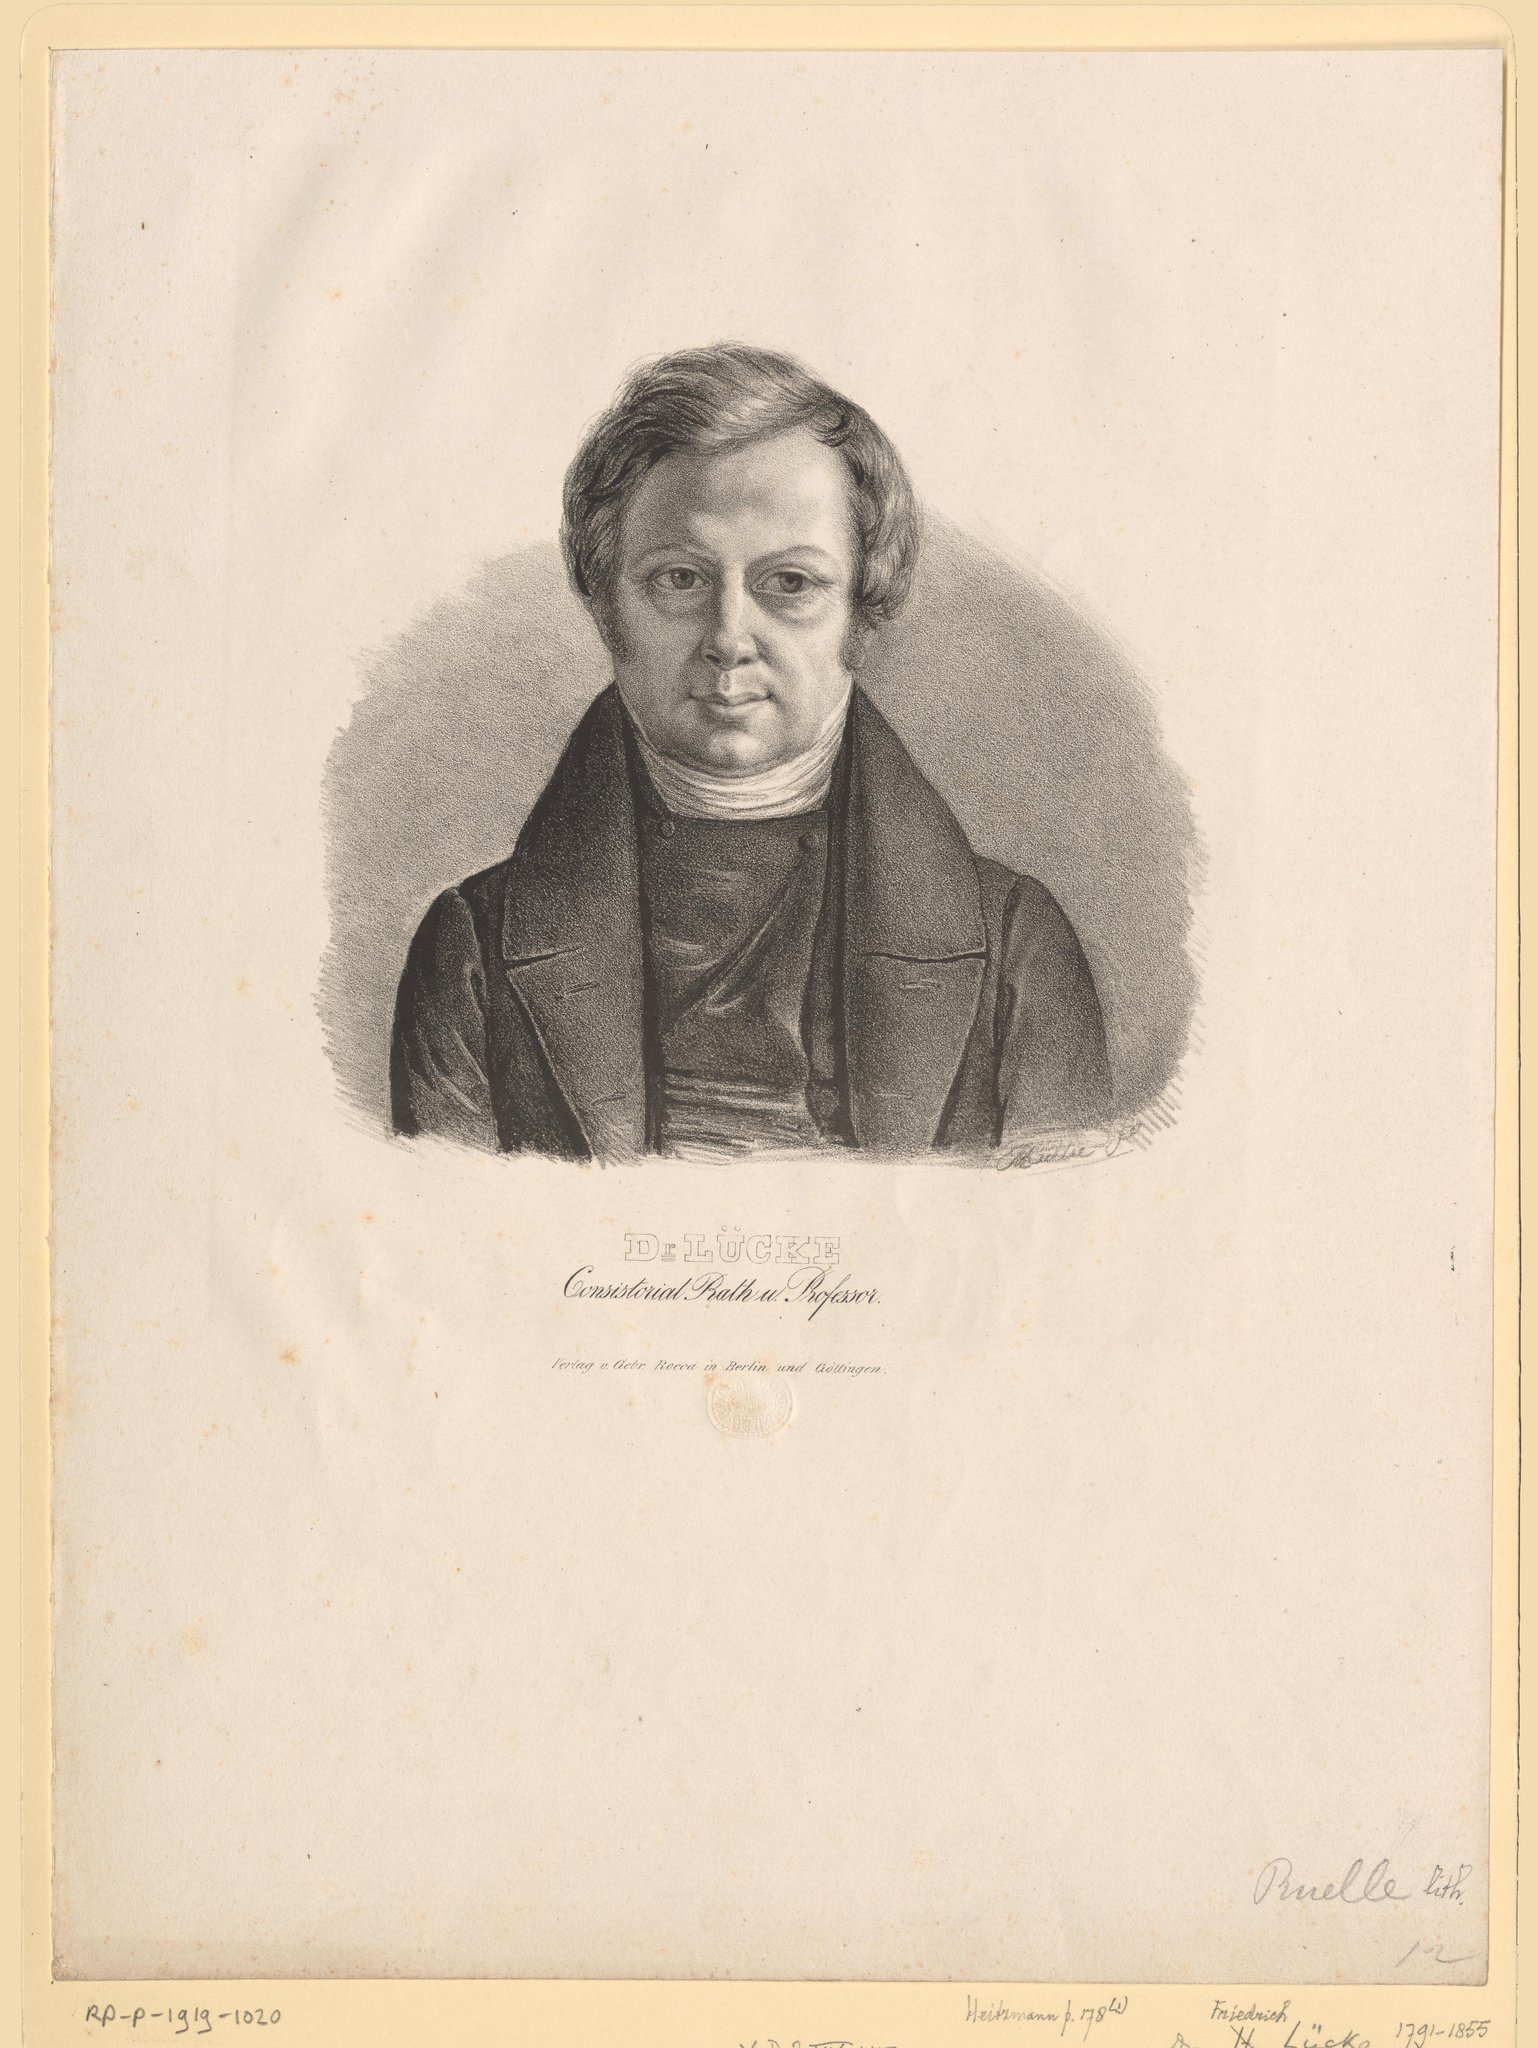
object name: print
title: Portret van Gottfried Christian Friedrich Lücke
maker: julius la ruelle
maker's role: print maker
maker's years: 1796-1865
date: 1830-1863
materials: paper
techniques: lithograph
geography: gottingen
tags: gottfried christian friedrich lücke, theologian, historical persons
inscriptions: check stamp: ‘Gebrueder Rocca/ in Göttingen’, collector's mark: Lugt 2228